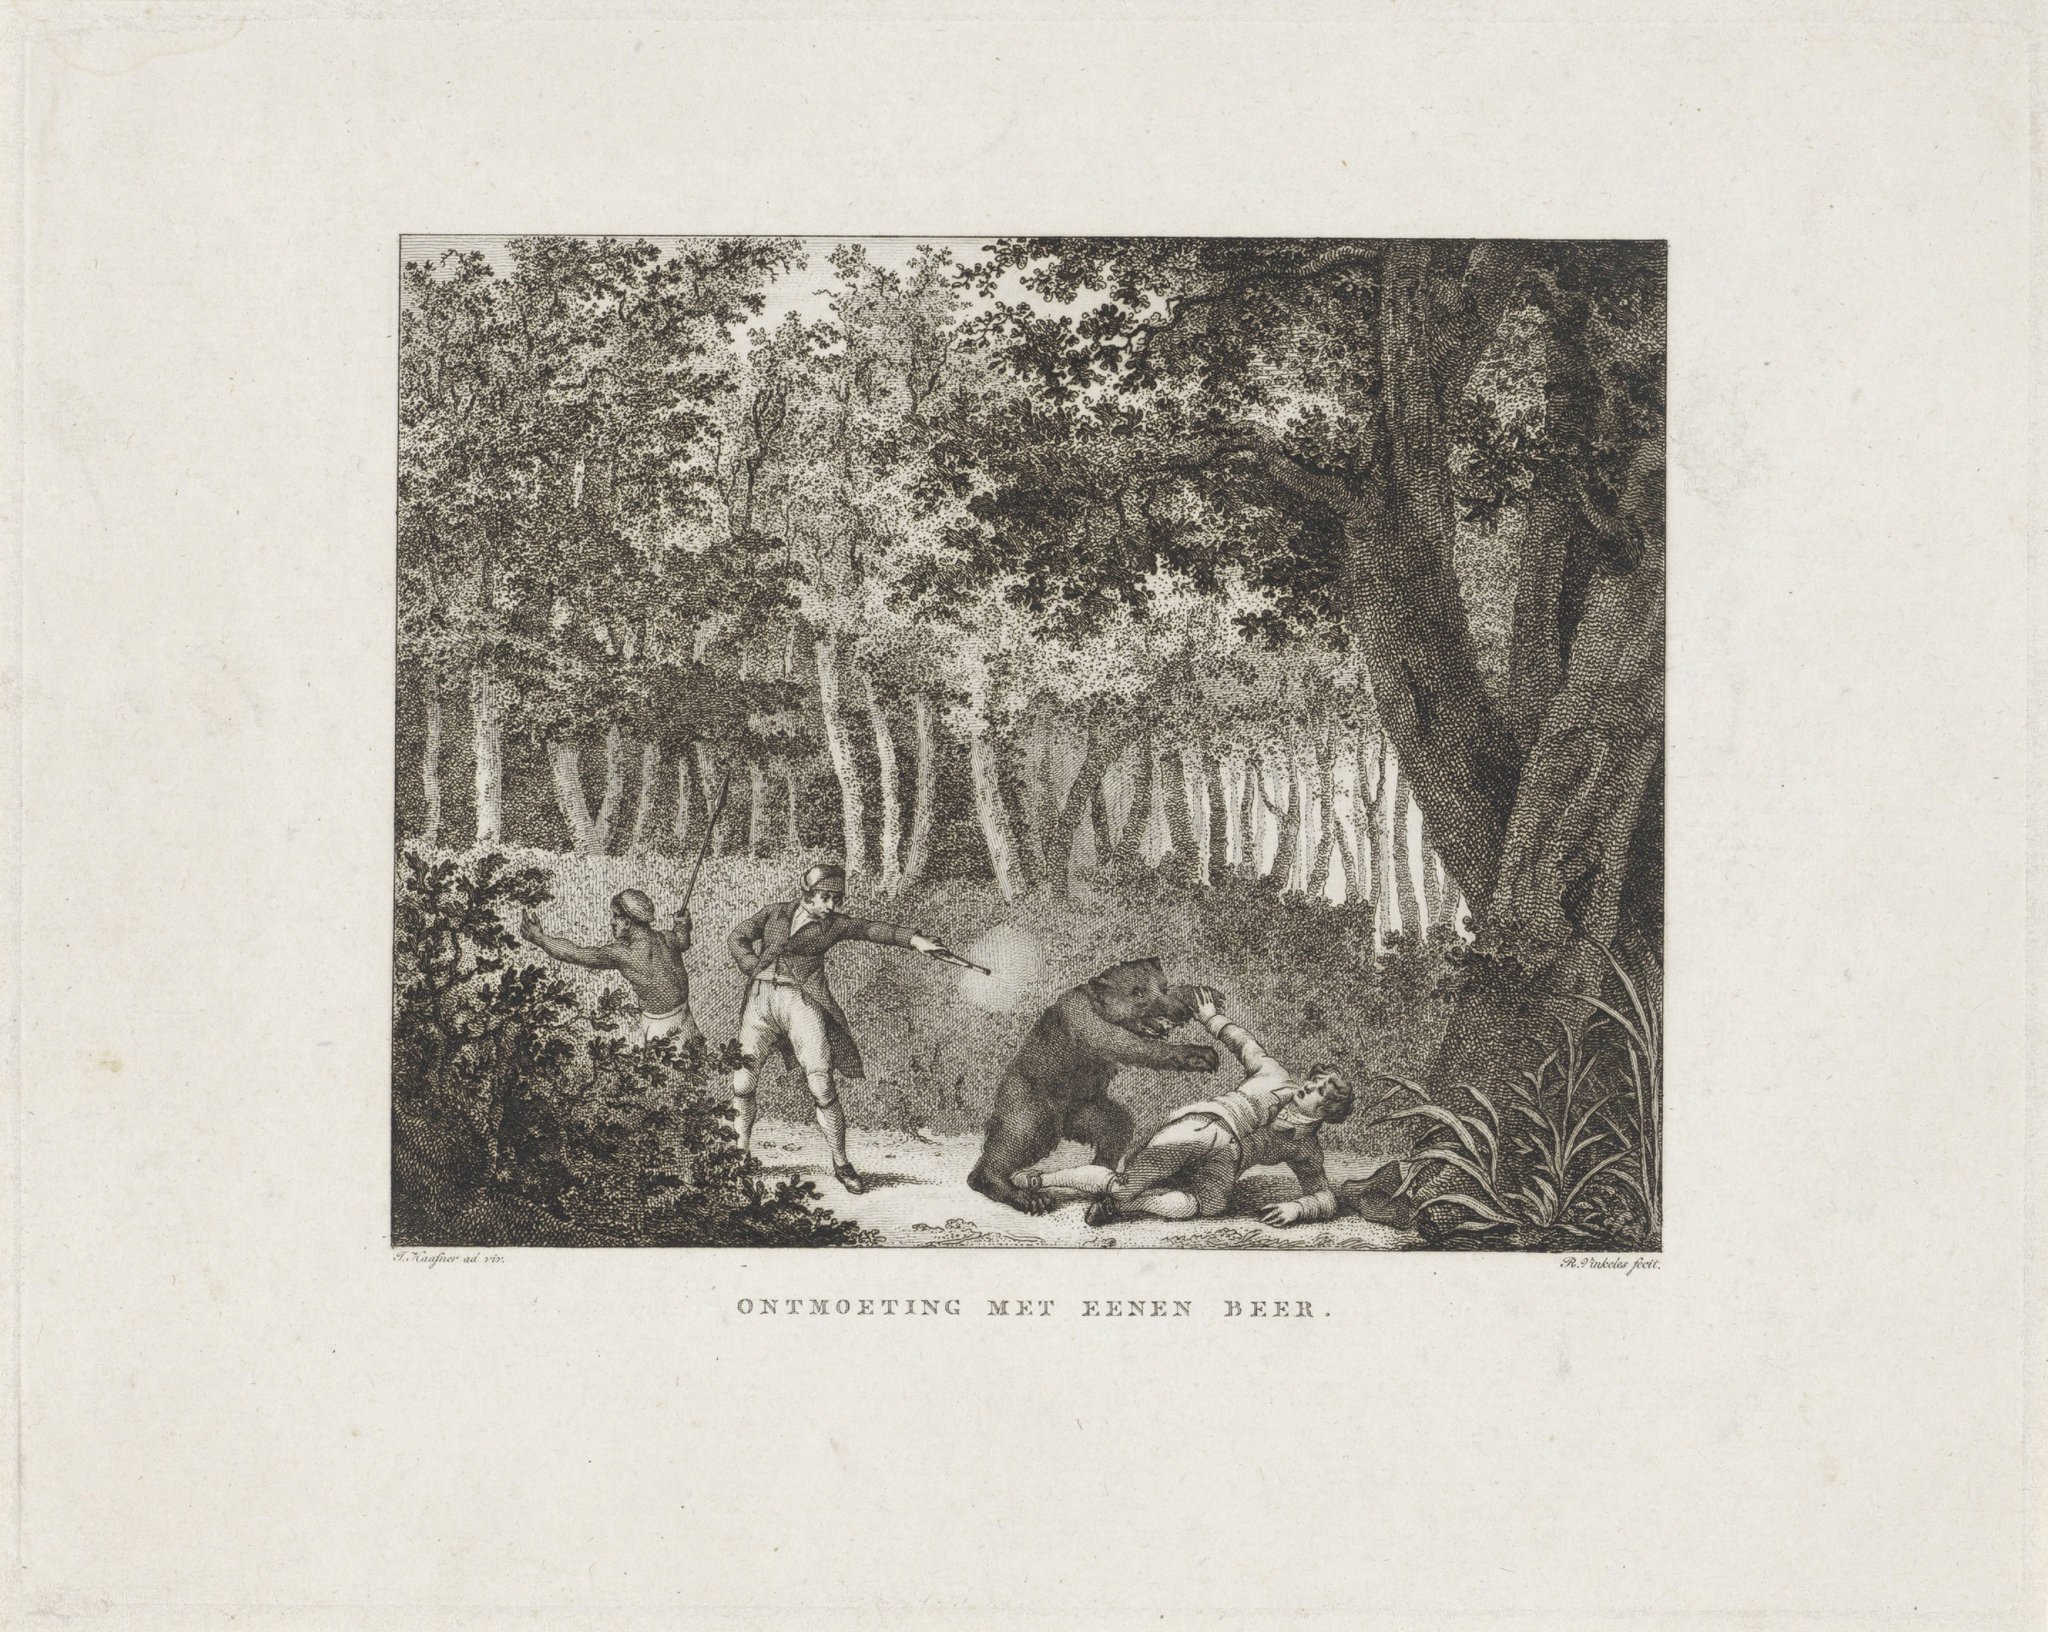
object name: print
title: Ontmoeting met eenen beer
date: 1810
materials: paper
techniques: engraving, etching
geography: amsterdam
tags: animals threatening man, beasts of prey, predatory animals: bear, firearms (with name), man killing animal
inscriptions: collector's mark: Lugt 2228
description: Illustratie in: Haafner, J. Reize te voet door het eiland Ceilon. Amsterdam: Johannes Allart, 1810.